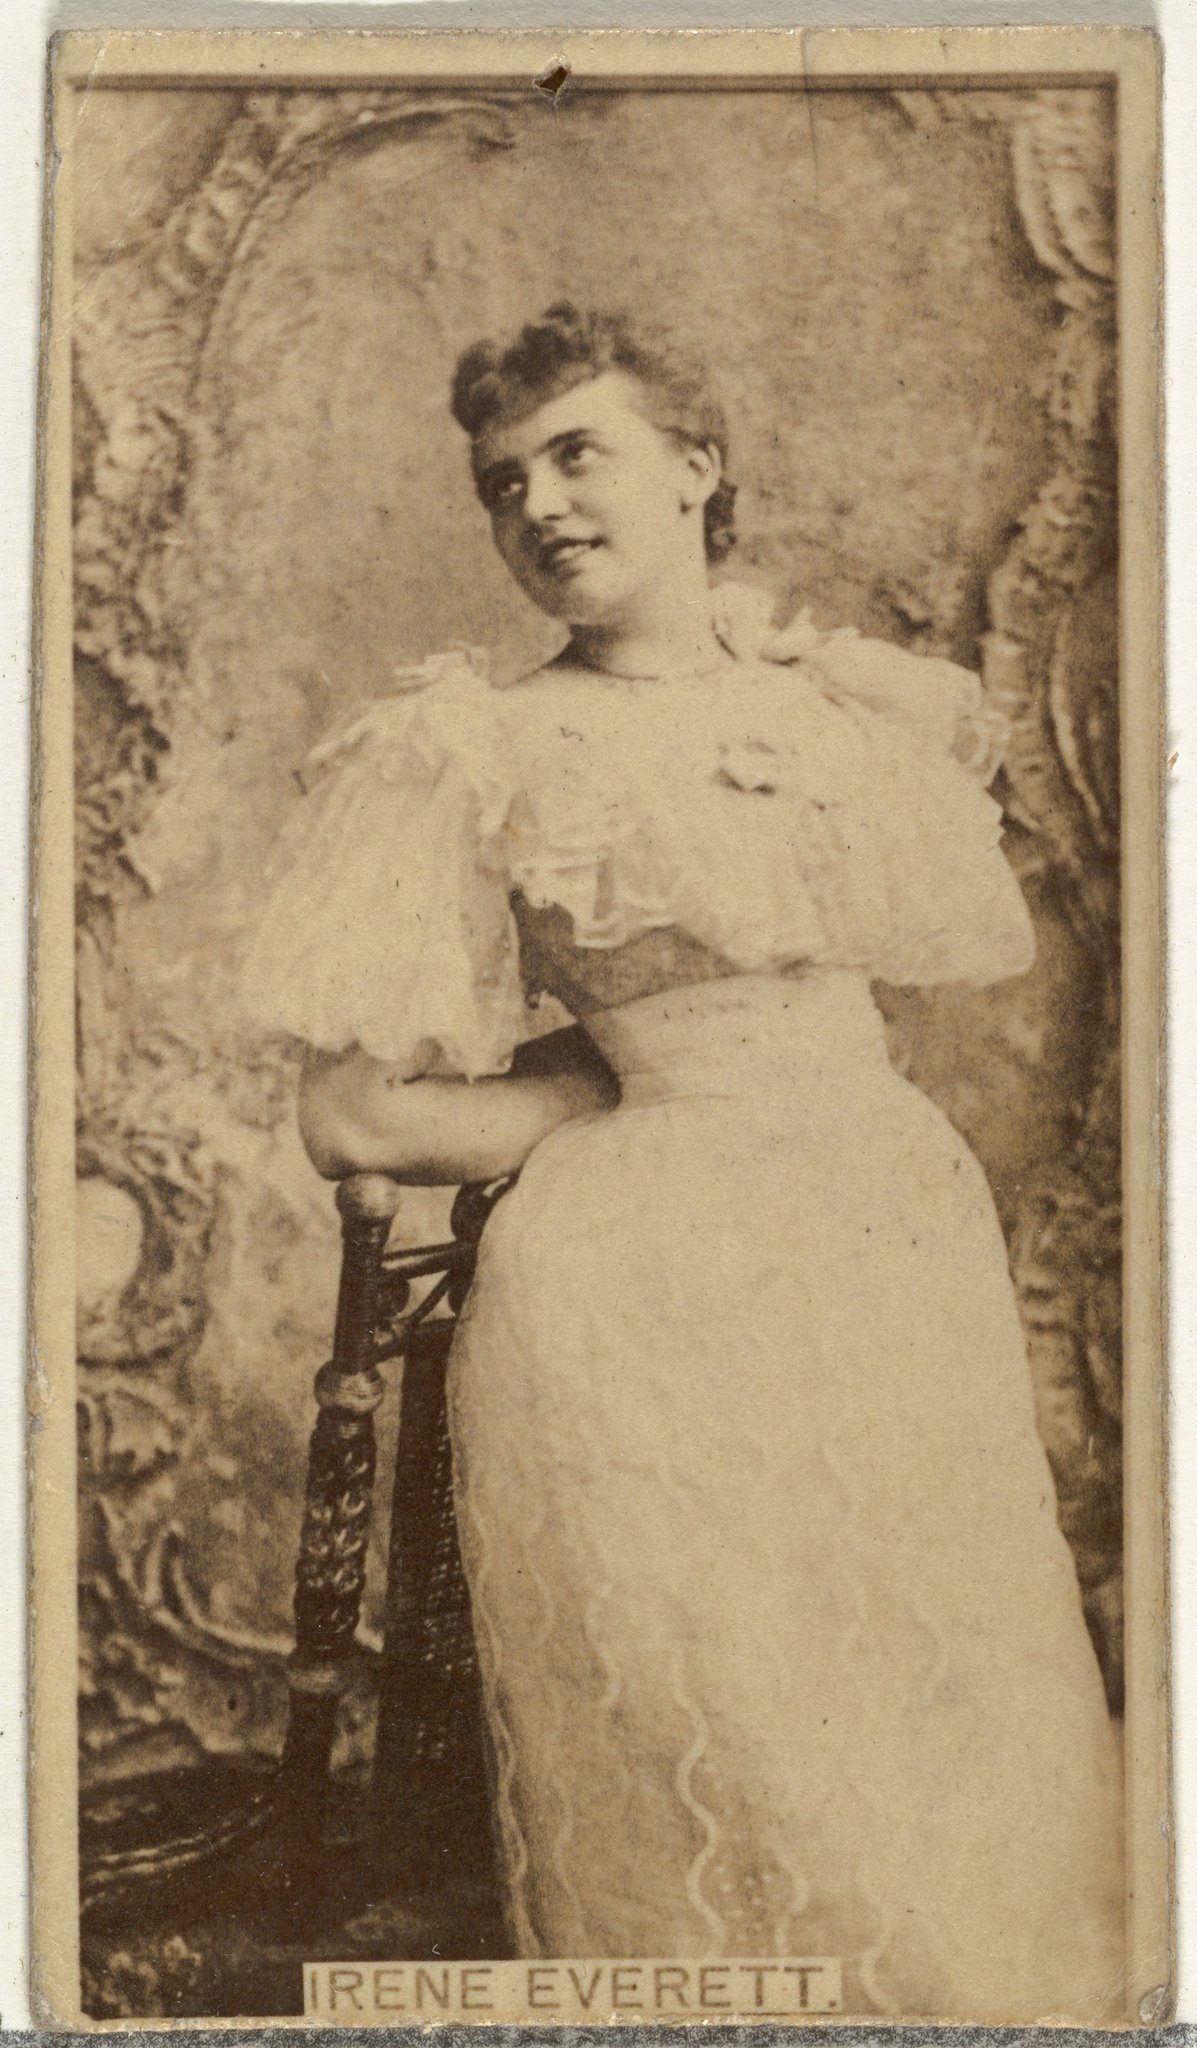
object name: photograph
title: Irene Everett, from the Actors and Actresses series (N145-8) issued by Duke Sons & Co. to promote Duke Cigarettes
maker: w. duke, sons & co.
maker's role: publisher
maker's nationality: american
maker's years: 1870-1920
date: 1891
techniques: albumen silver print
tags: portraits,women,actresses